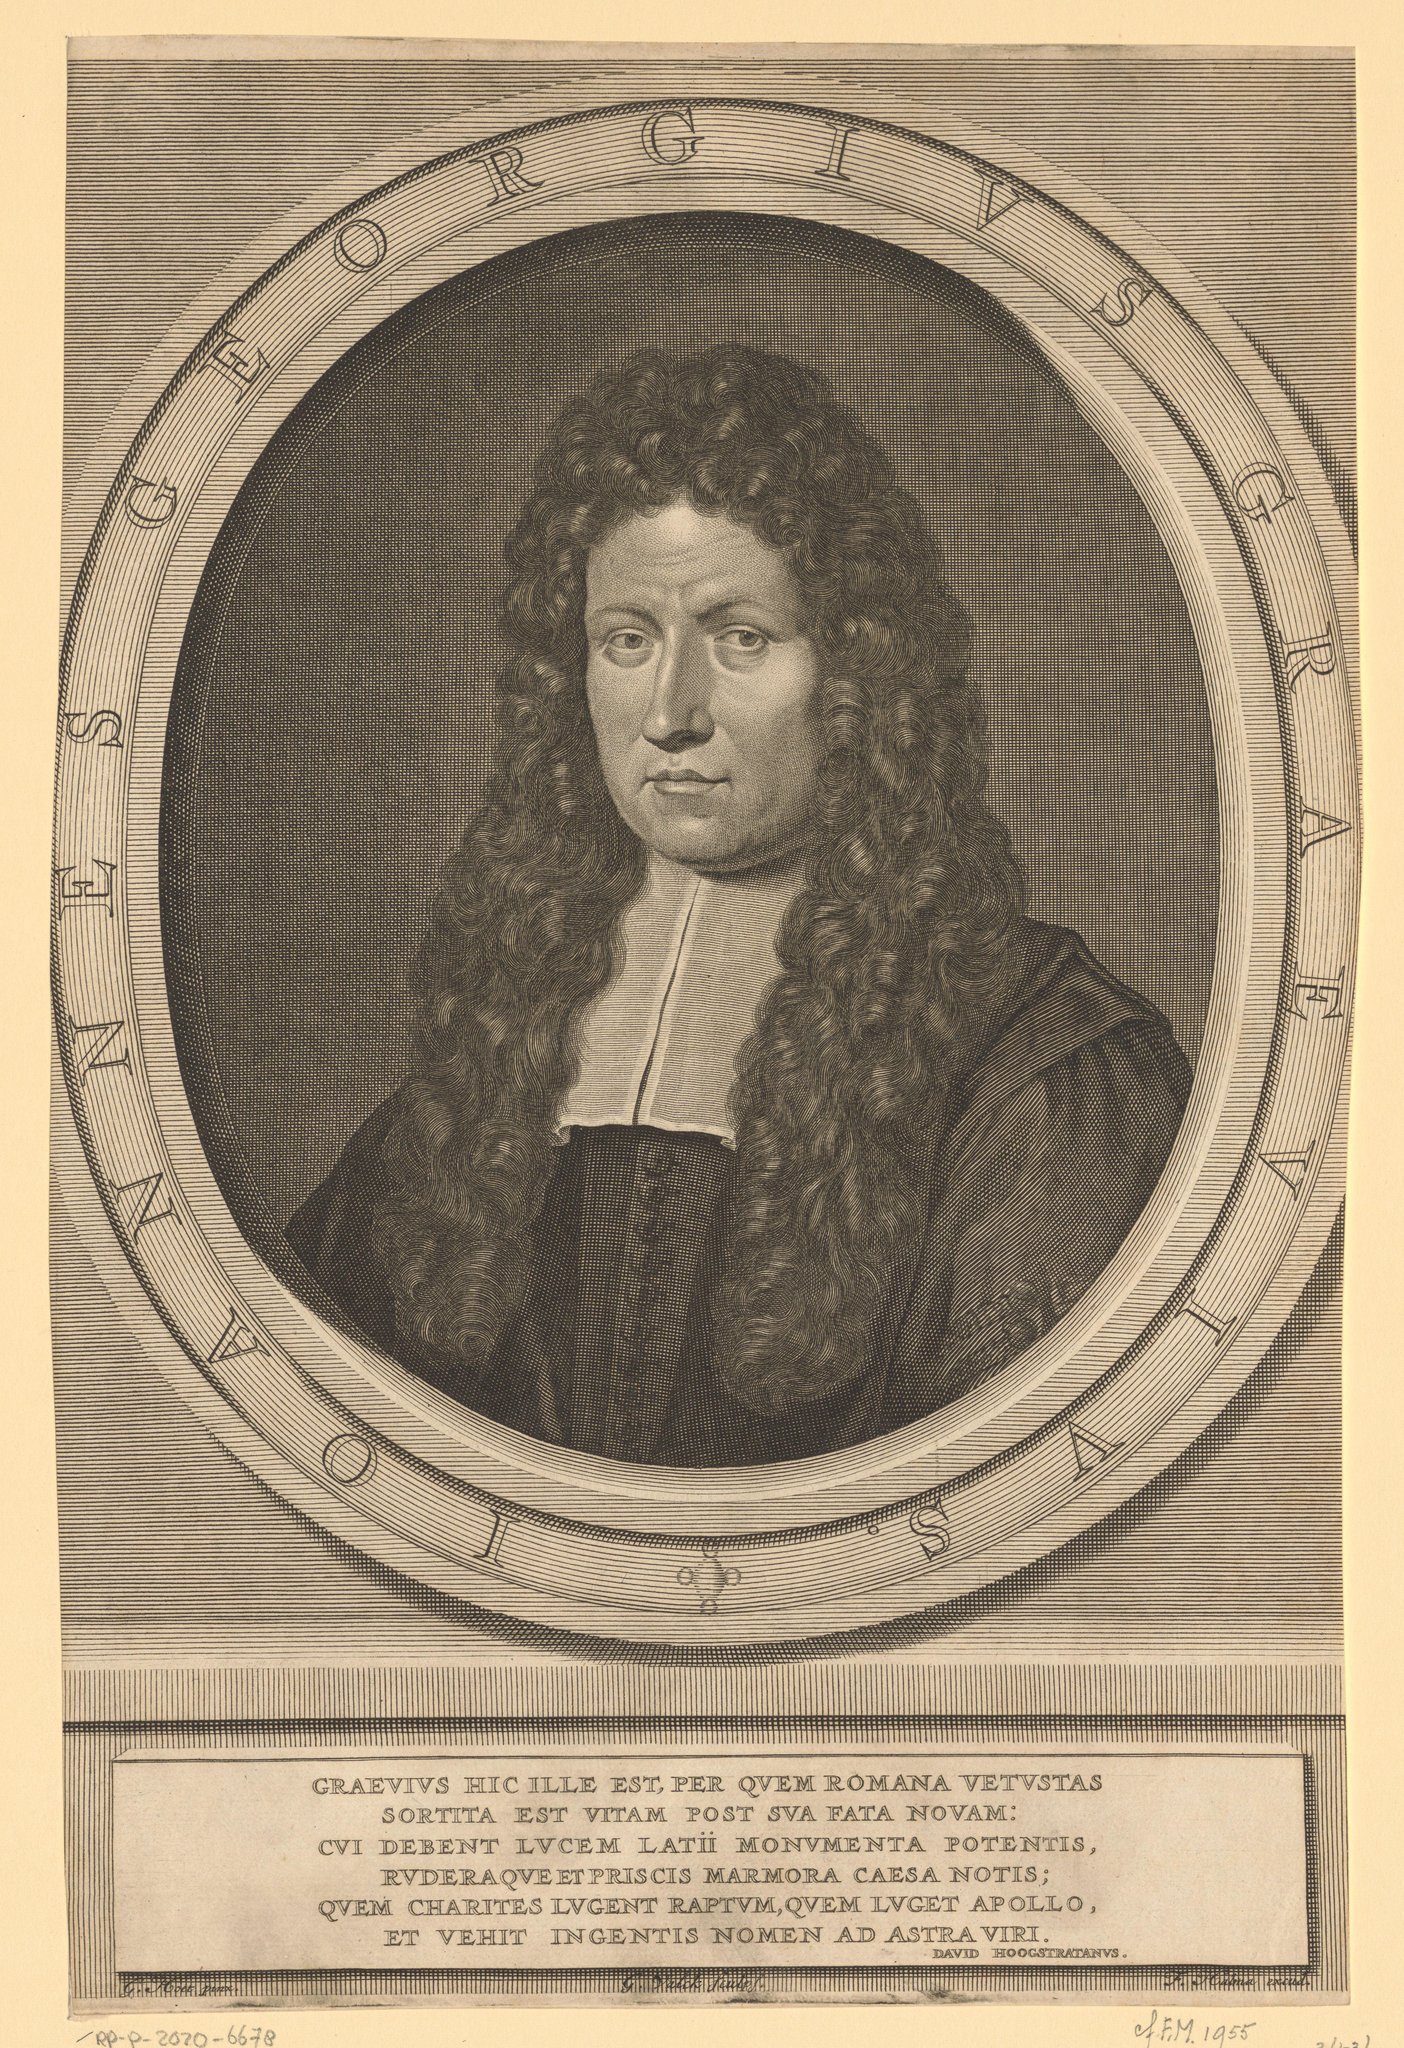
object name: print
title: Portret van Johann George Graevius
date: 1680-1720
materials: paper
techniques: engraving, etching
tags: historical persons, scholar, philosopher (+ portrait of scholar, scientist)